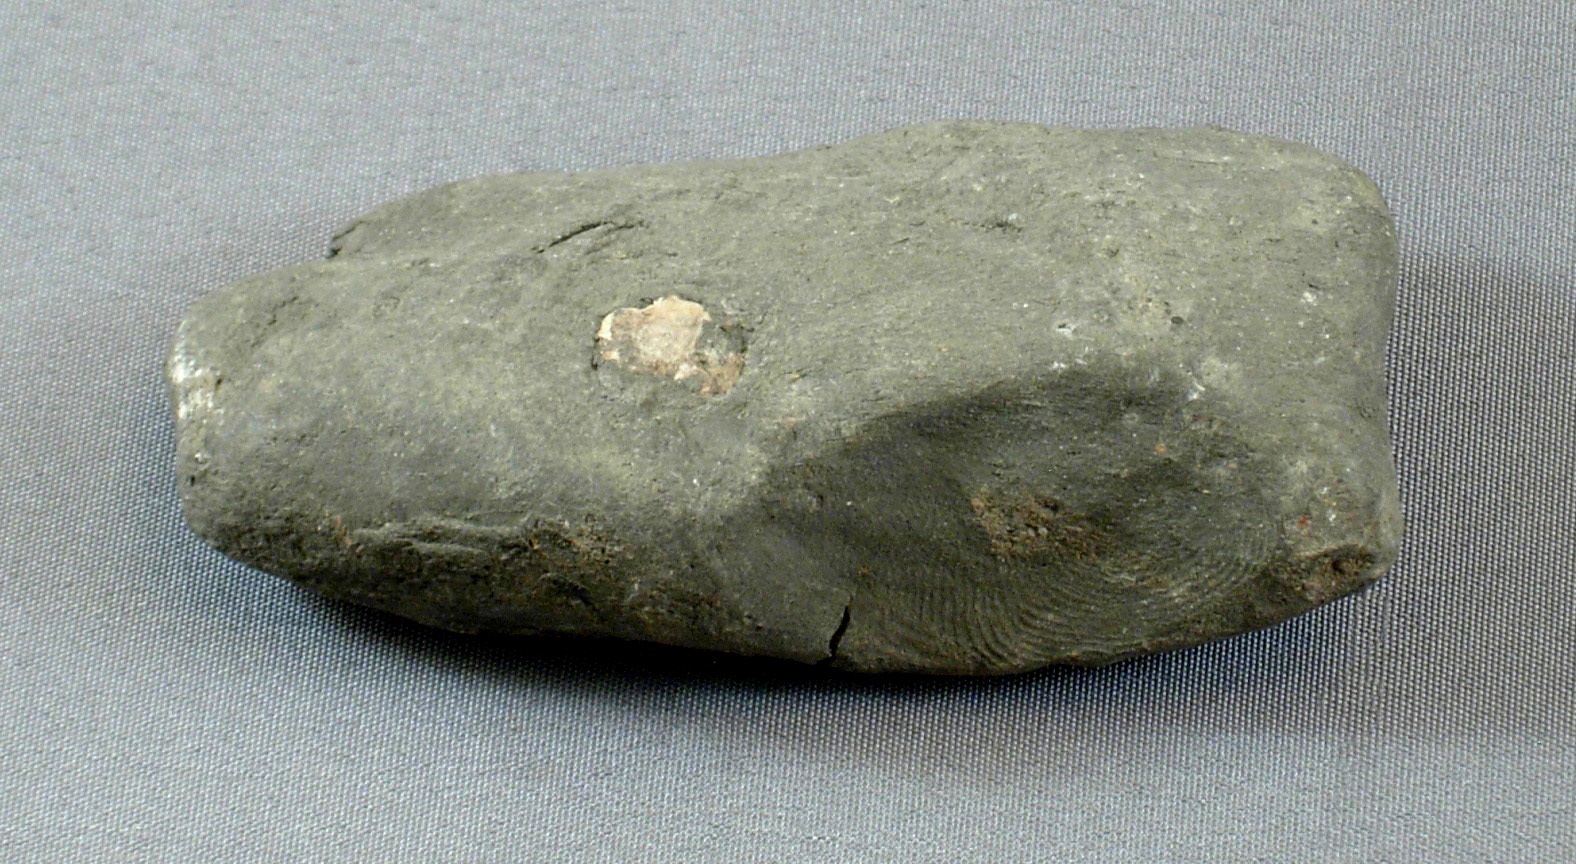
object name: mud pat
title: Pat of Mud for Sealing from Tutankhamun's Embalming Cache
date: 1336-1327 BCE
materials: mud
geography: egypt